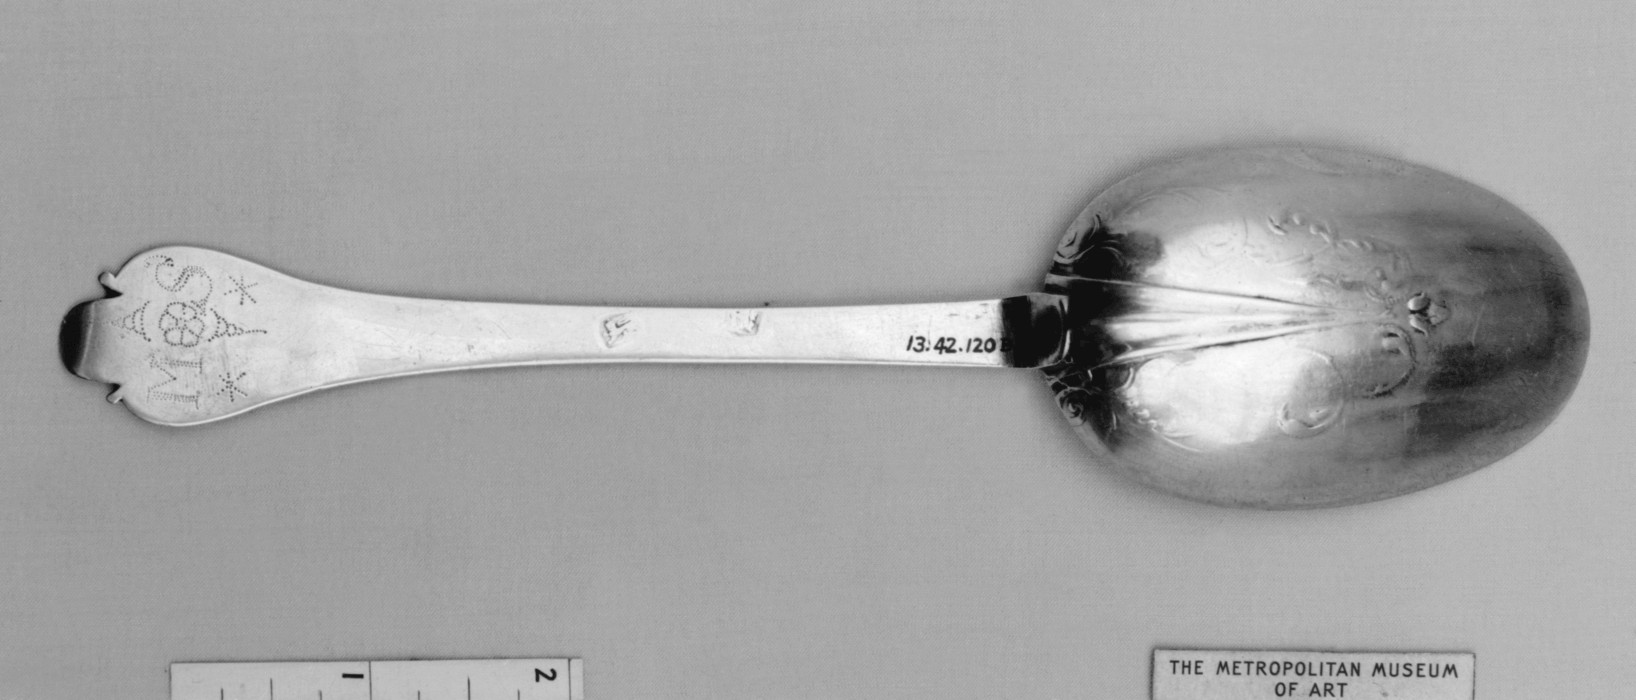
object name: spoon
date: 1685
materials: silver